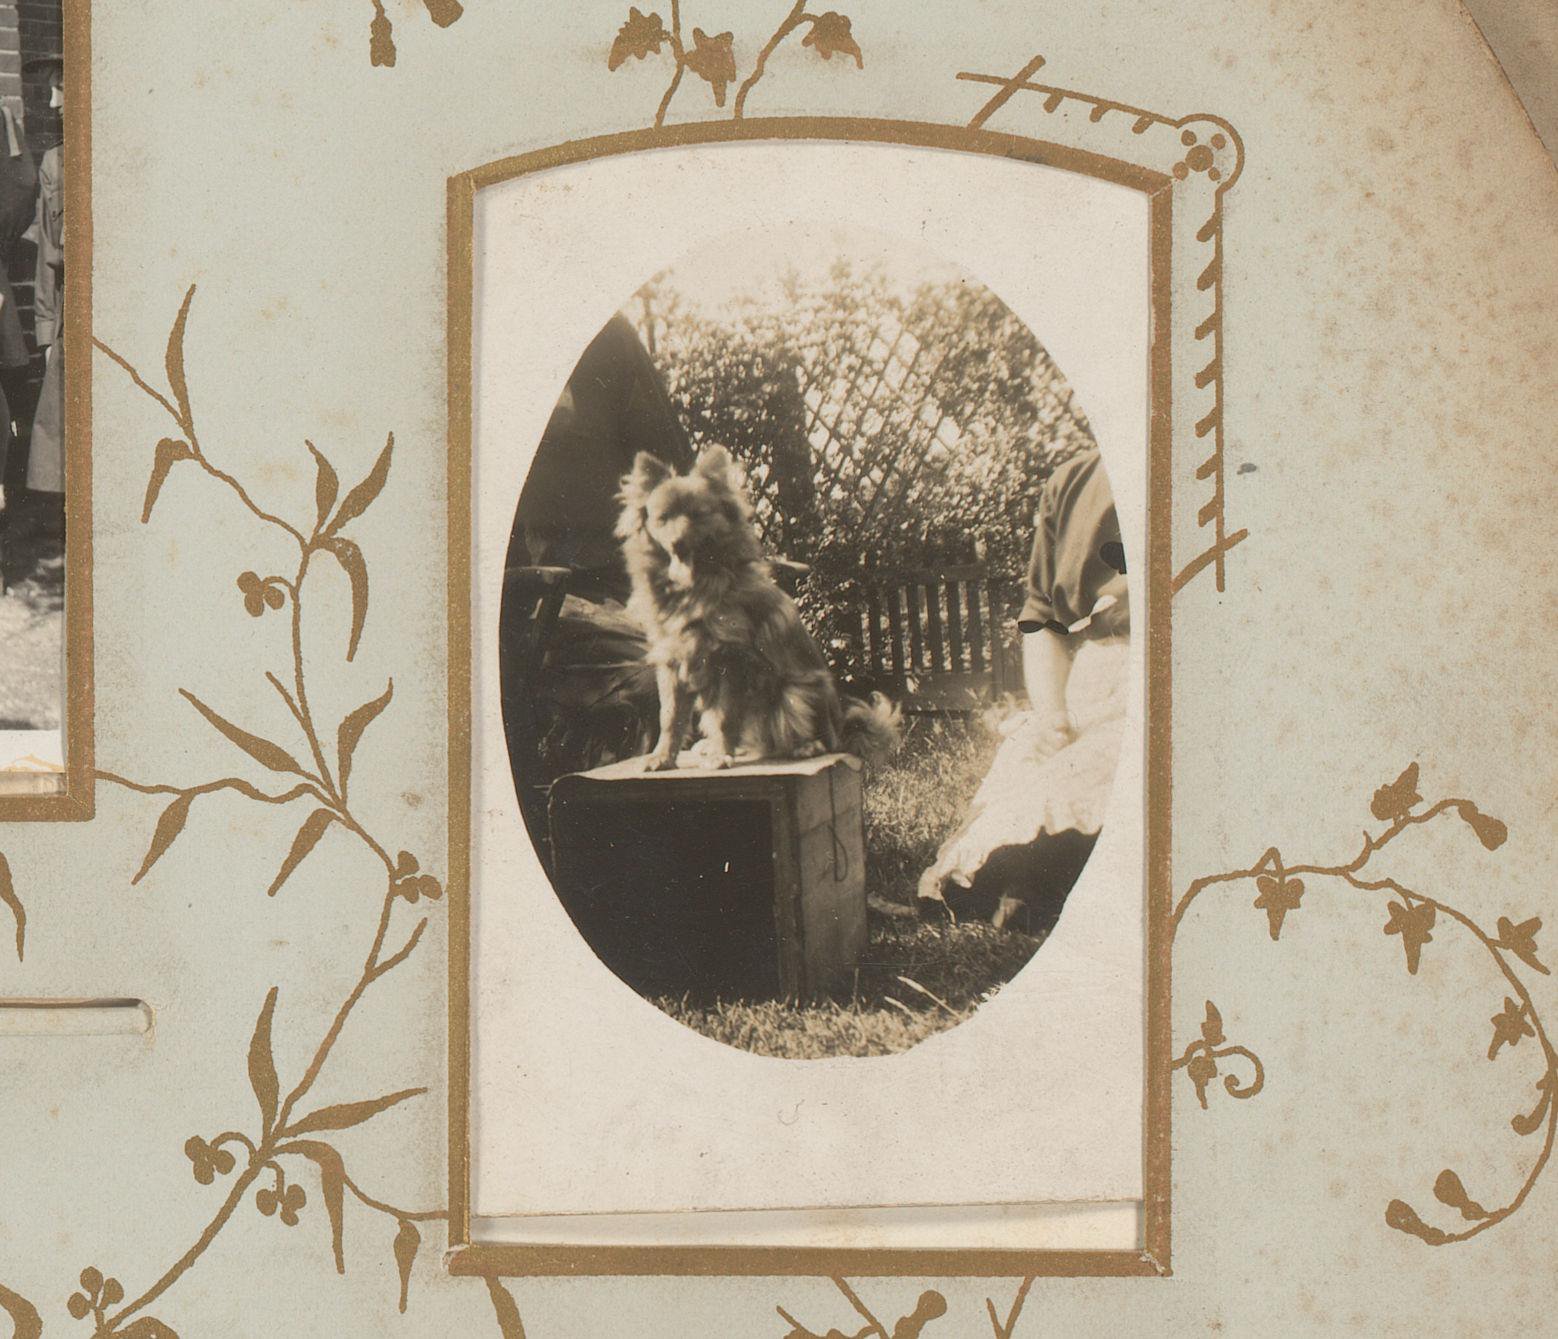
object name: album leaf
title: Portret van een hond op een kist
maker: Anonymous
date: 1899-1940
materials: cardboard, photographic support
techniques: gelatin silver print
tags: chest, coffer, dog